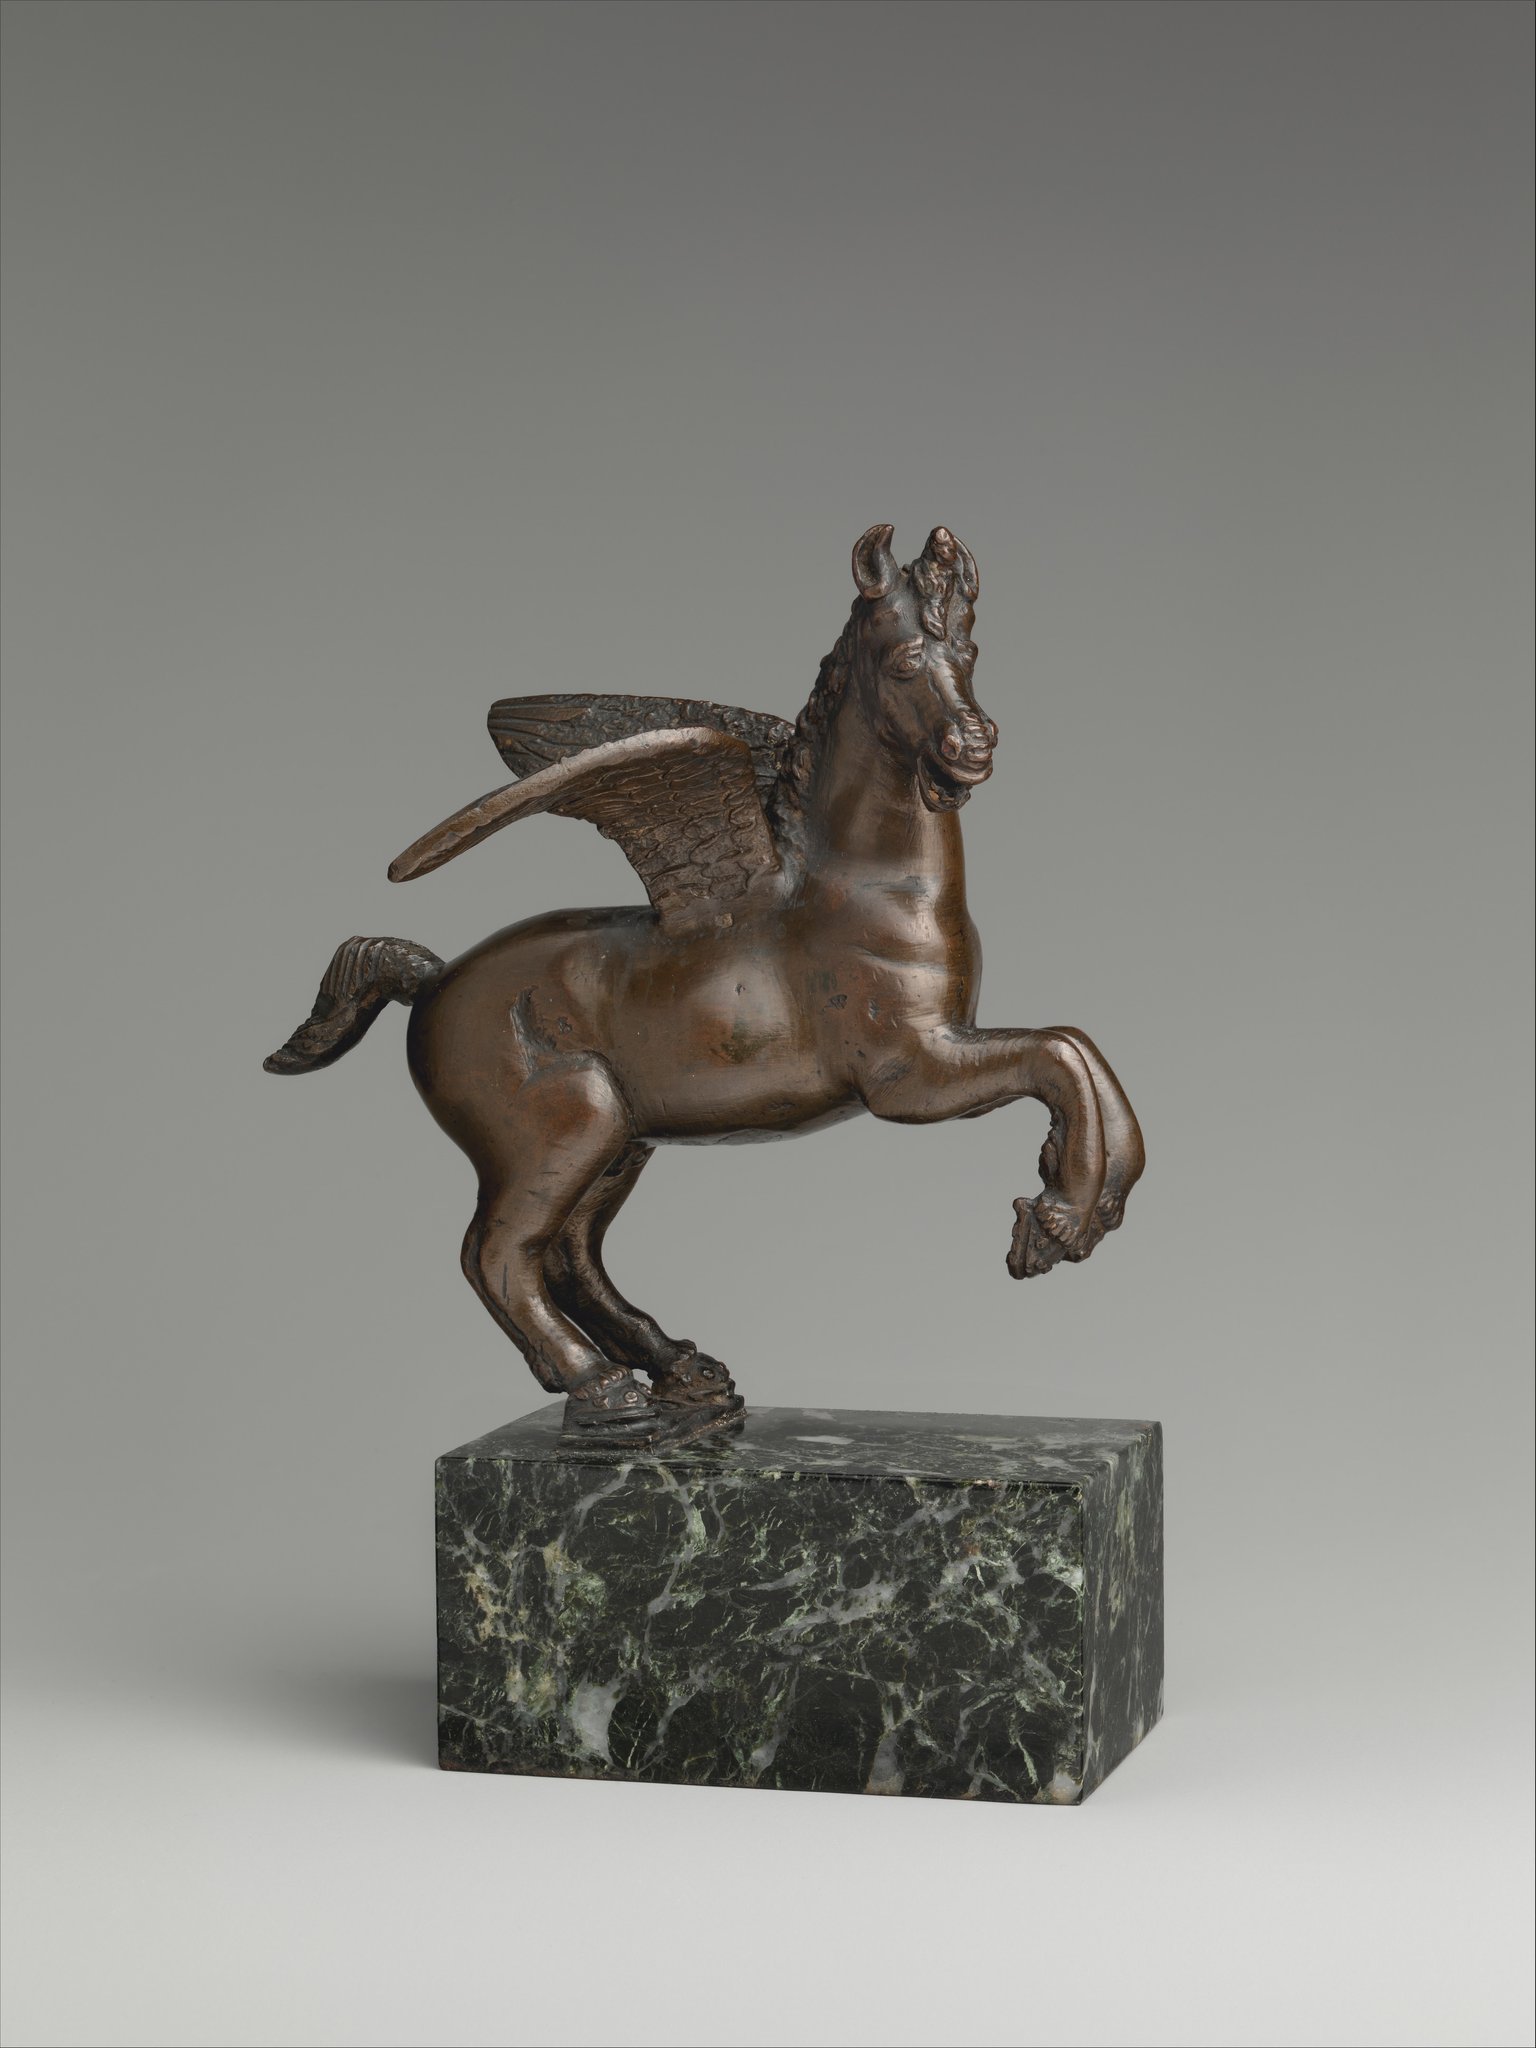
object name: statuette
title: Pegasus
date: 1575-1599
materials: bronze, marble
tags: pegasus